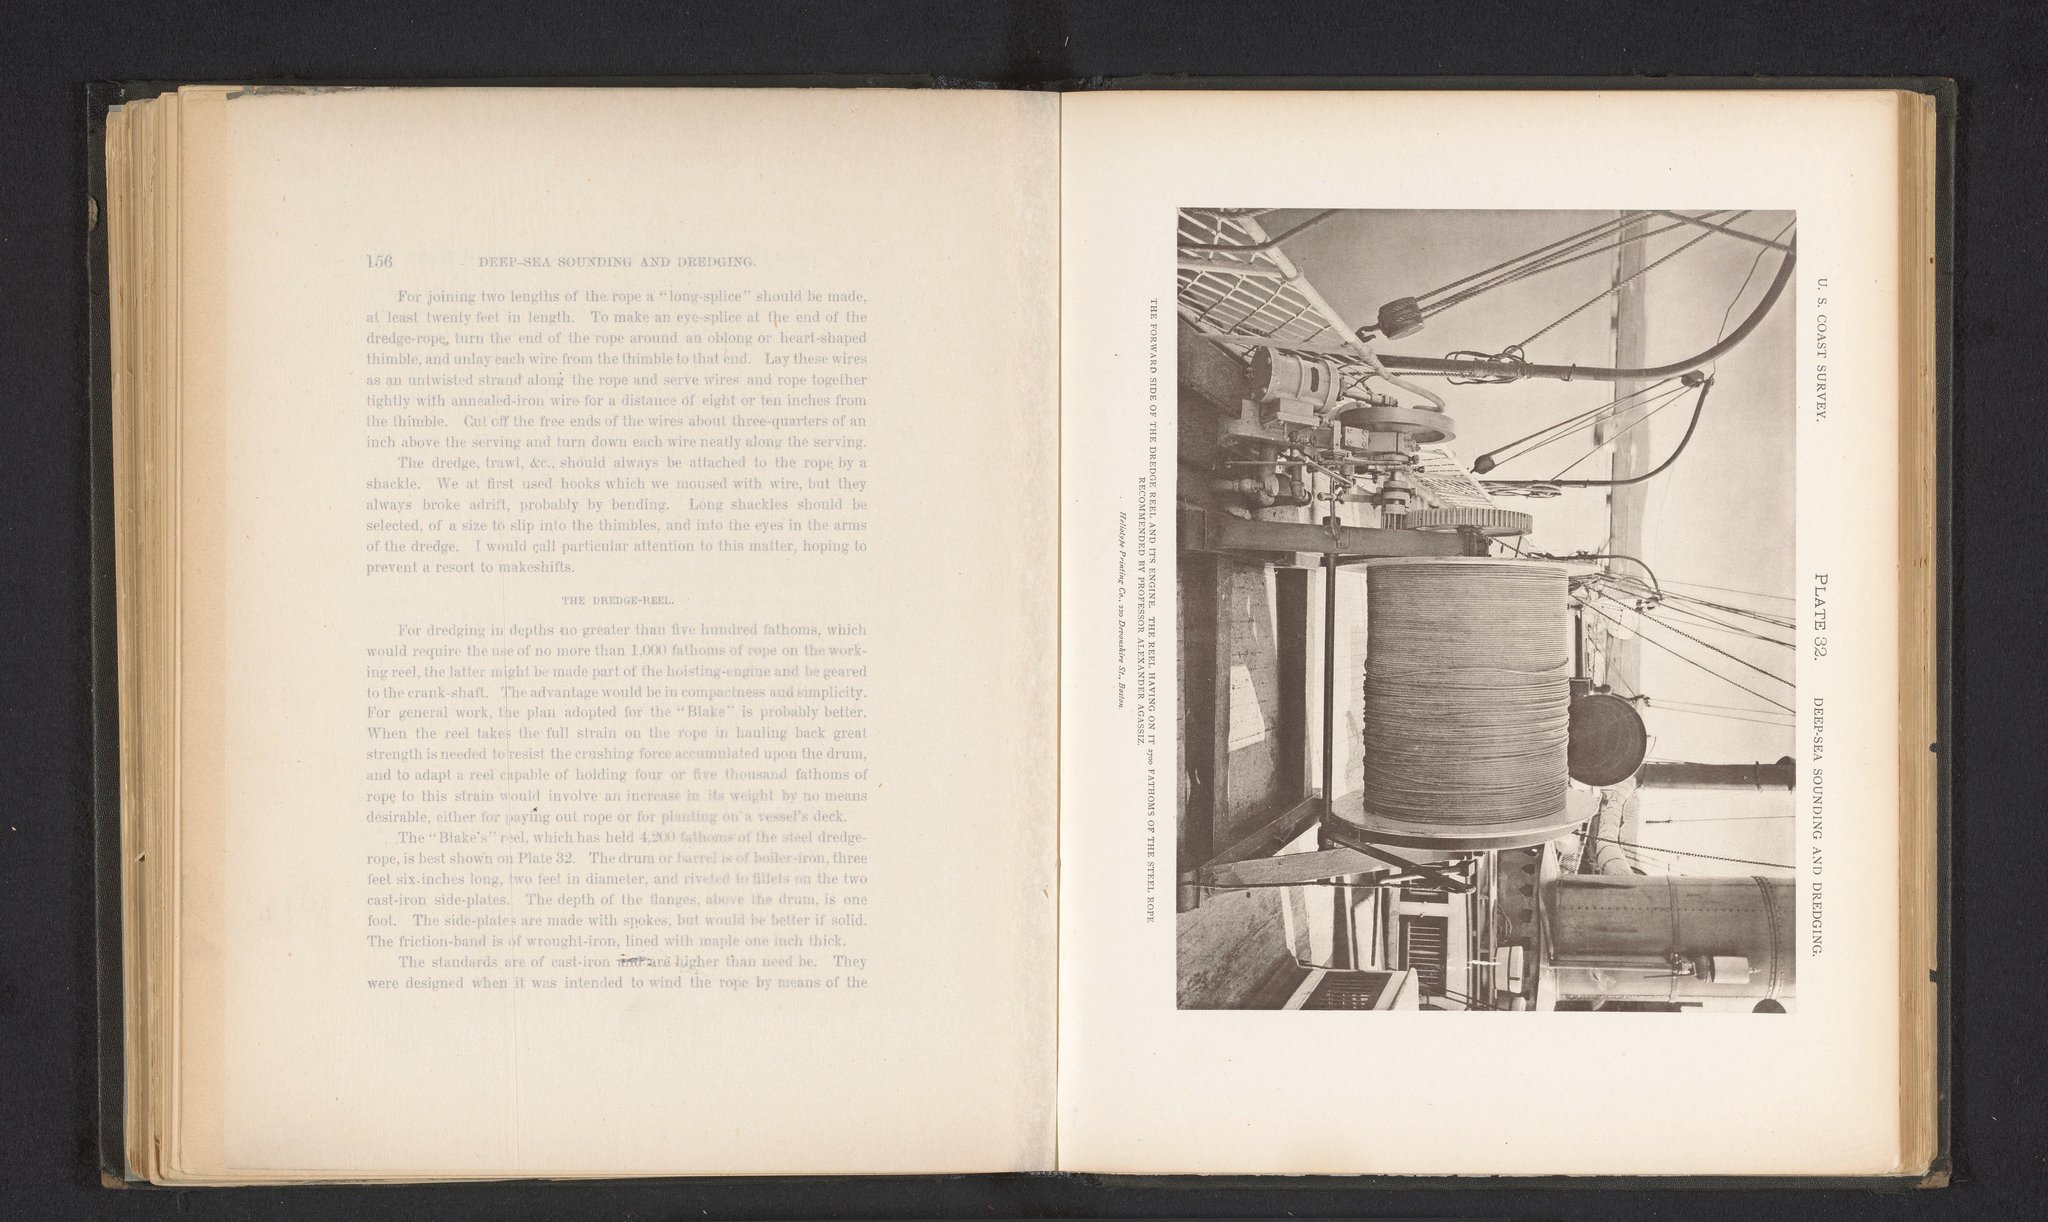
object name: page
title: Baggerhaspel op het dek van de George S. Blake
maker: Anonymous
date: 1870-1880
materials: paper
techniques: photograph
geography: boston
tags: ships (in general), dredge, dredging machine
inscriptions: name: ‘Heliotype Printing Co., 220 Devonshire St., Boston.’, number: ‘Plate 32.’, inscription: ‘The forward side of the dredge reel and its engine. The reel having on it 2700 fathoms of the steel rope recommended by professor Alexander Agassiz.’